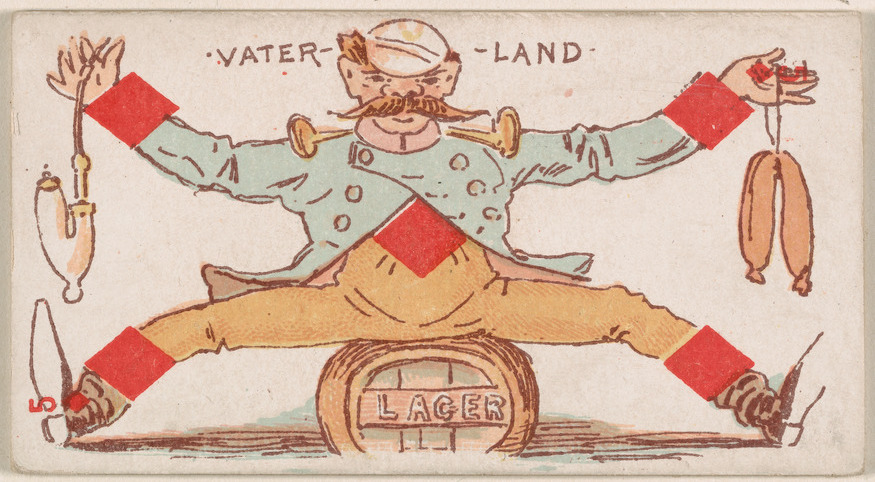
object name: print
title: Five of Diamonds, Vater-Land, from Harlequin Cards, 2nd Series (N220) issued by Kinney Bros.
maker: kinney brothers tobacco company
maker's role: publisher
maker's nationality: american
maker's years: 1869-2011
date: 1889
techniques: color lithograph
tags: men,playing cards